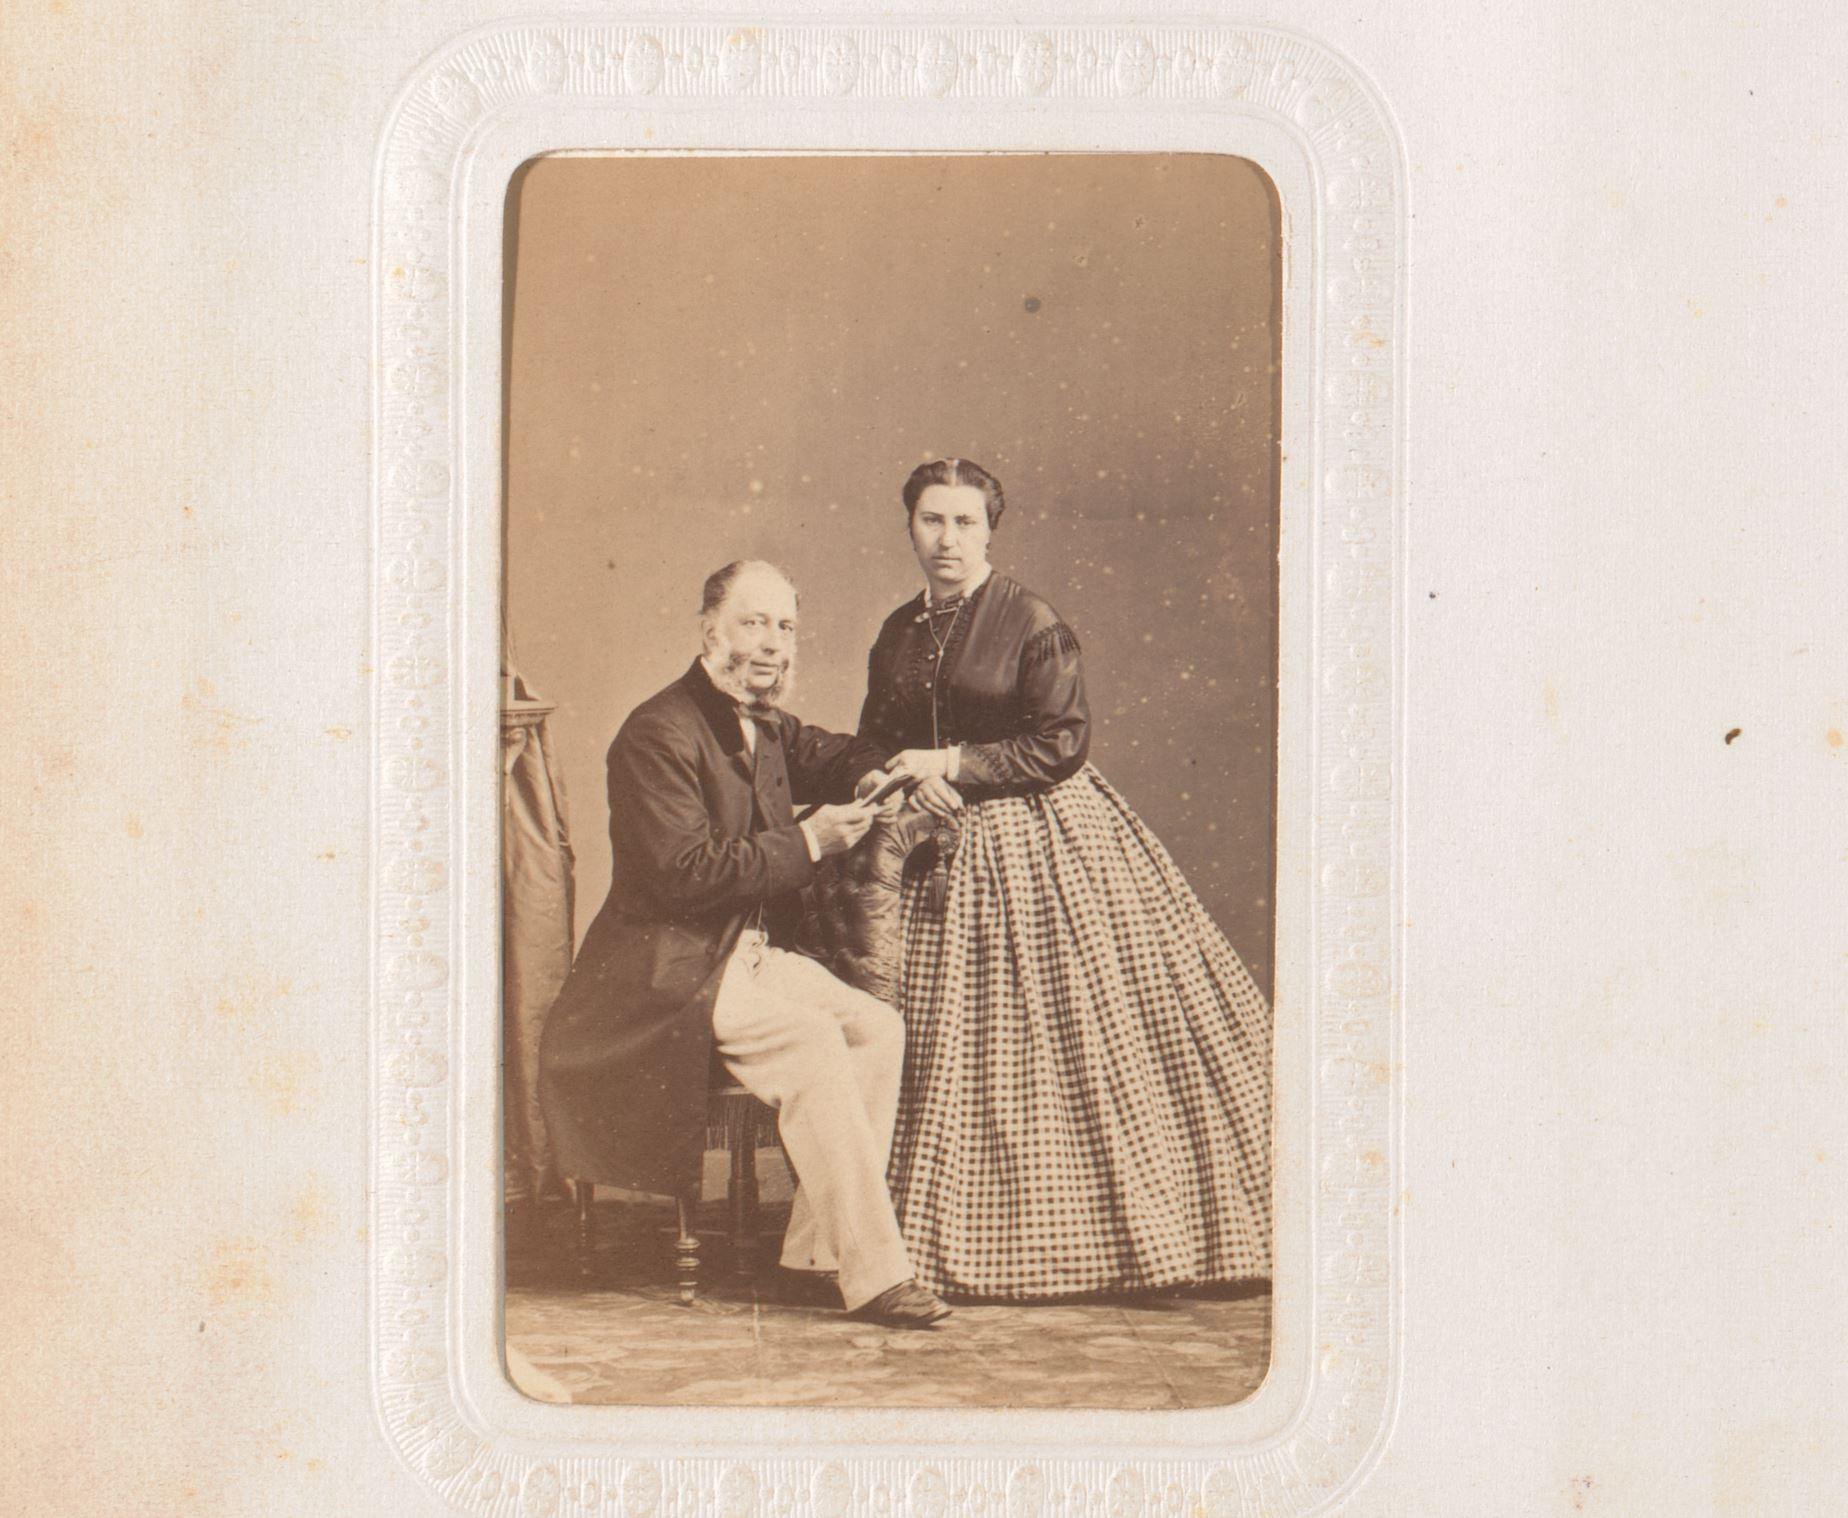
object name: photograph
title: Portret van een echtpaar, de man zittend op een stoel en de vrouw staand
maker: Anonymous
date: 1860-1900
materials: cardboard, photographic support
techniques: albumen print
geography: netherlands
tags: historical persons - bb - woman, historical persons, marriage, married couple, 'matrimonium'